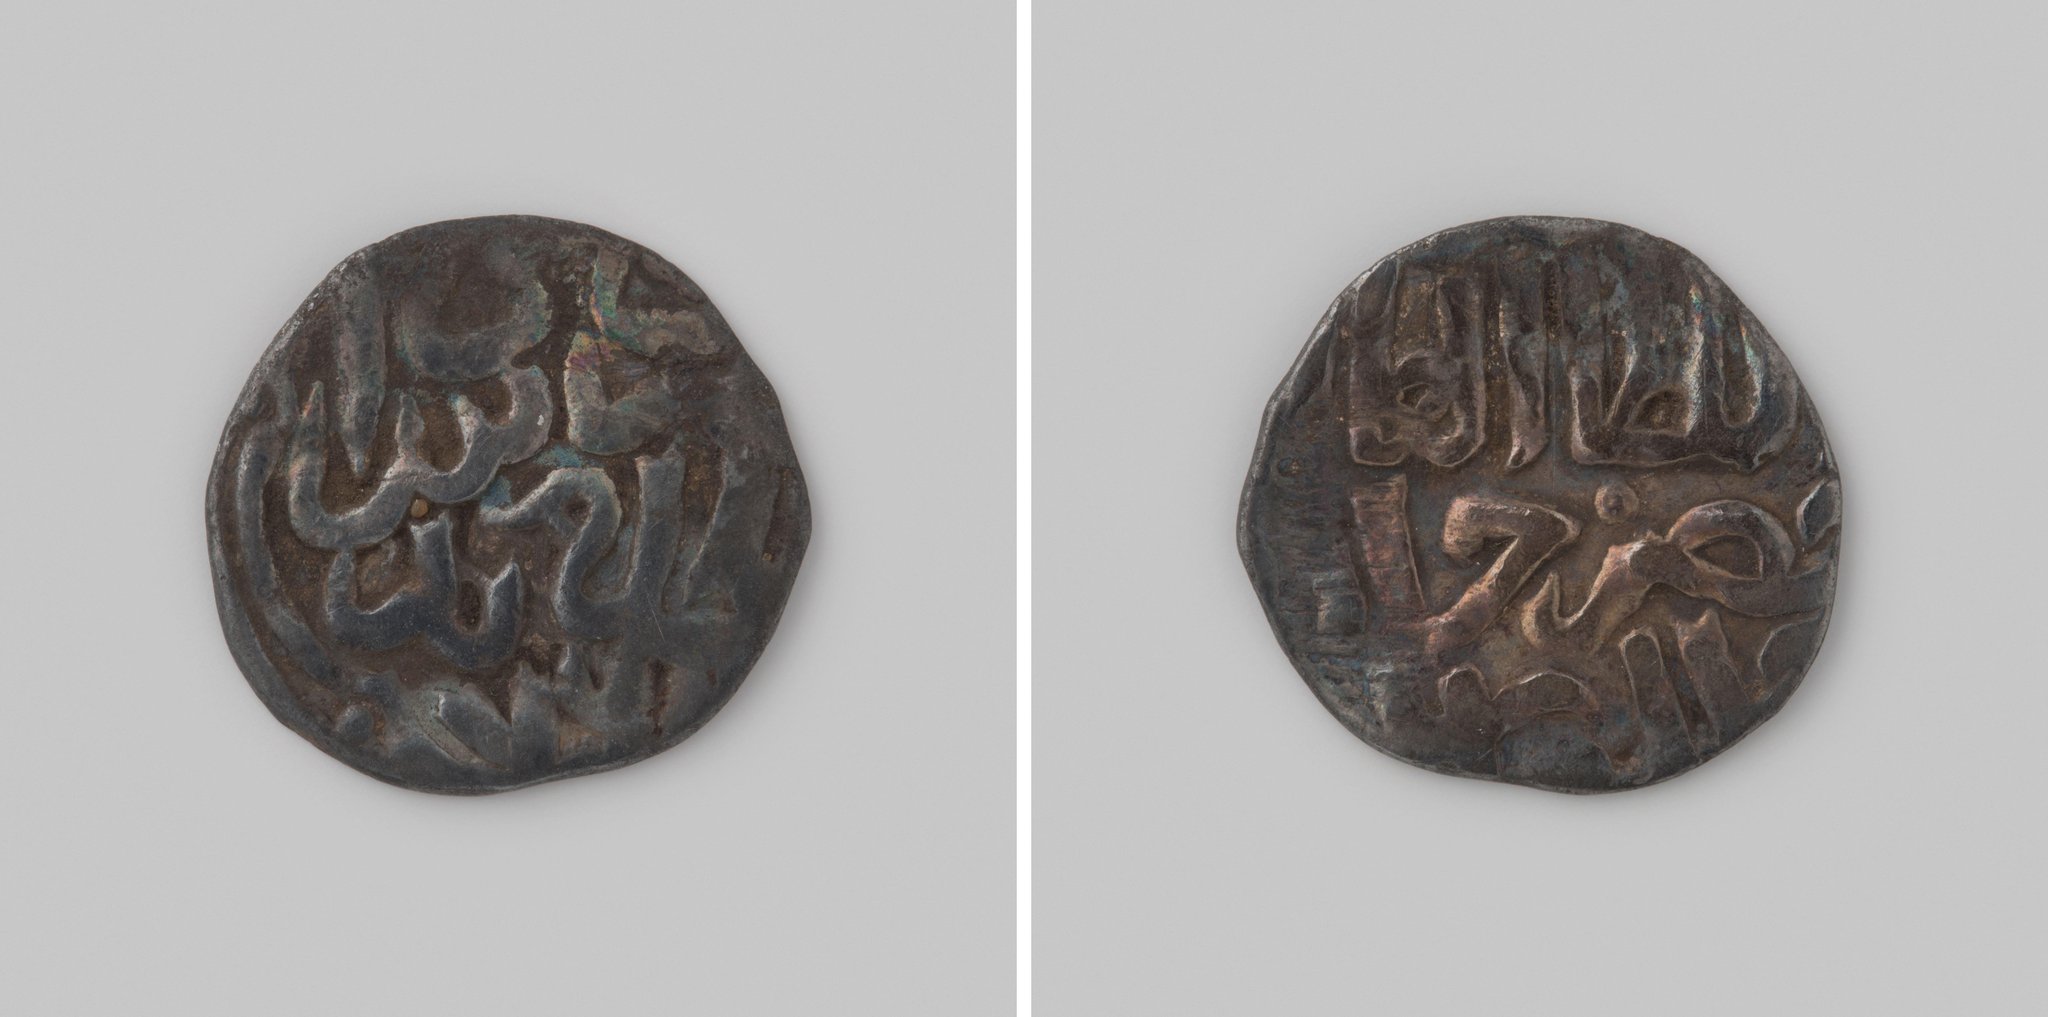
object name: coin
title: Ondetermineerbare munt uit Perzië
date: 1500-1900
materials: silver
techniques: striking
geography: iran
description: Zilveren munt. Voorzijde: in Arabische lettertekens opschrift in vier regels: kalima [=geloofsbelijdenis]?. Keerzijde: opschrift n vier regels. Gladde rand.